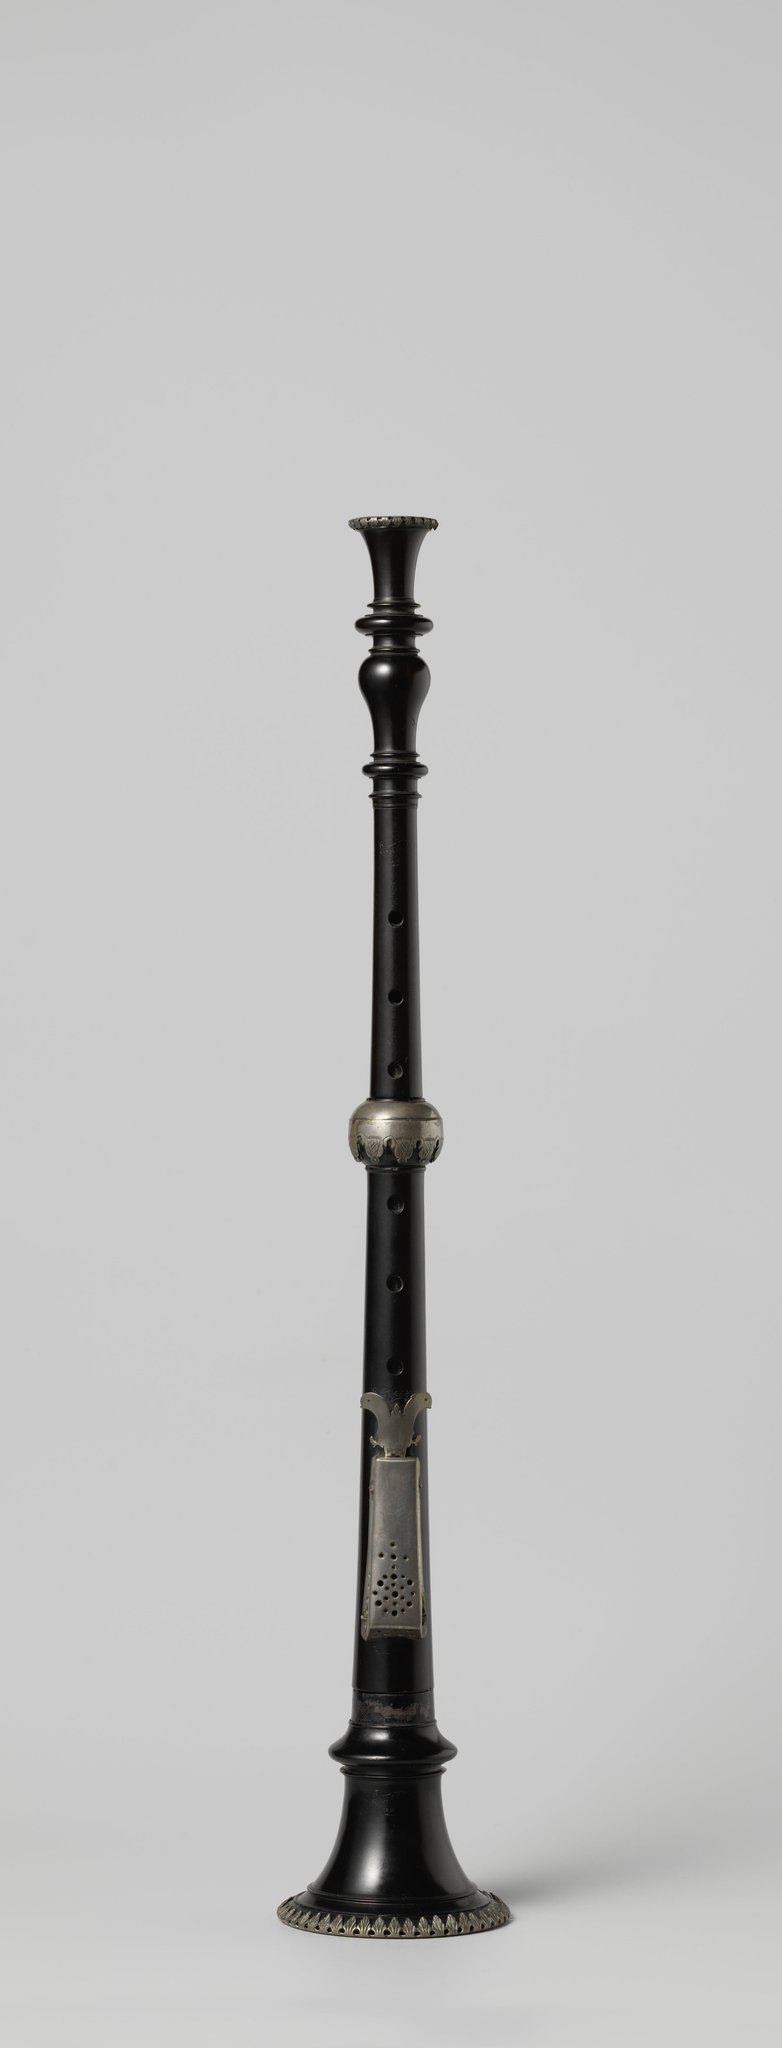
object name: wind instrument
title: Oboe or Shawm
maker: richard haka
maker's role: musical instrument maker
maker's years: 1646-1705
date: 1680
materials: wood, silver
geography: amsterdam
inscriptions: mark, above hole 1, under hole 6 and at the top of the short bell flare, stamped: ‘R.HAKA’ R.HAKA [in a scroll]/ [a low fleur-de-lis]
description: The oboe was invented by French woodwind instrument makers at the service of Louis XIV. For its distinctive timbre, it was quickly adopted all over Europe into the main body of the orchestra. French instruments were imported to the Dutch Republic where, from about 1680, a prosperous community of makers mainly based in Amsterdam, produced some of the most richly decorated oboes ever made.